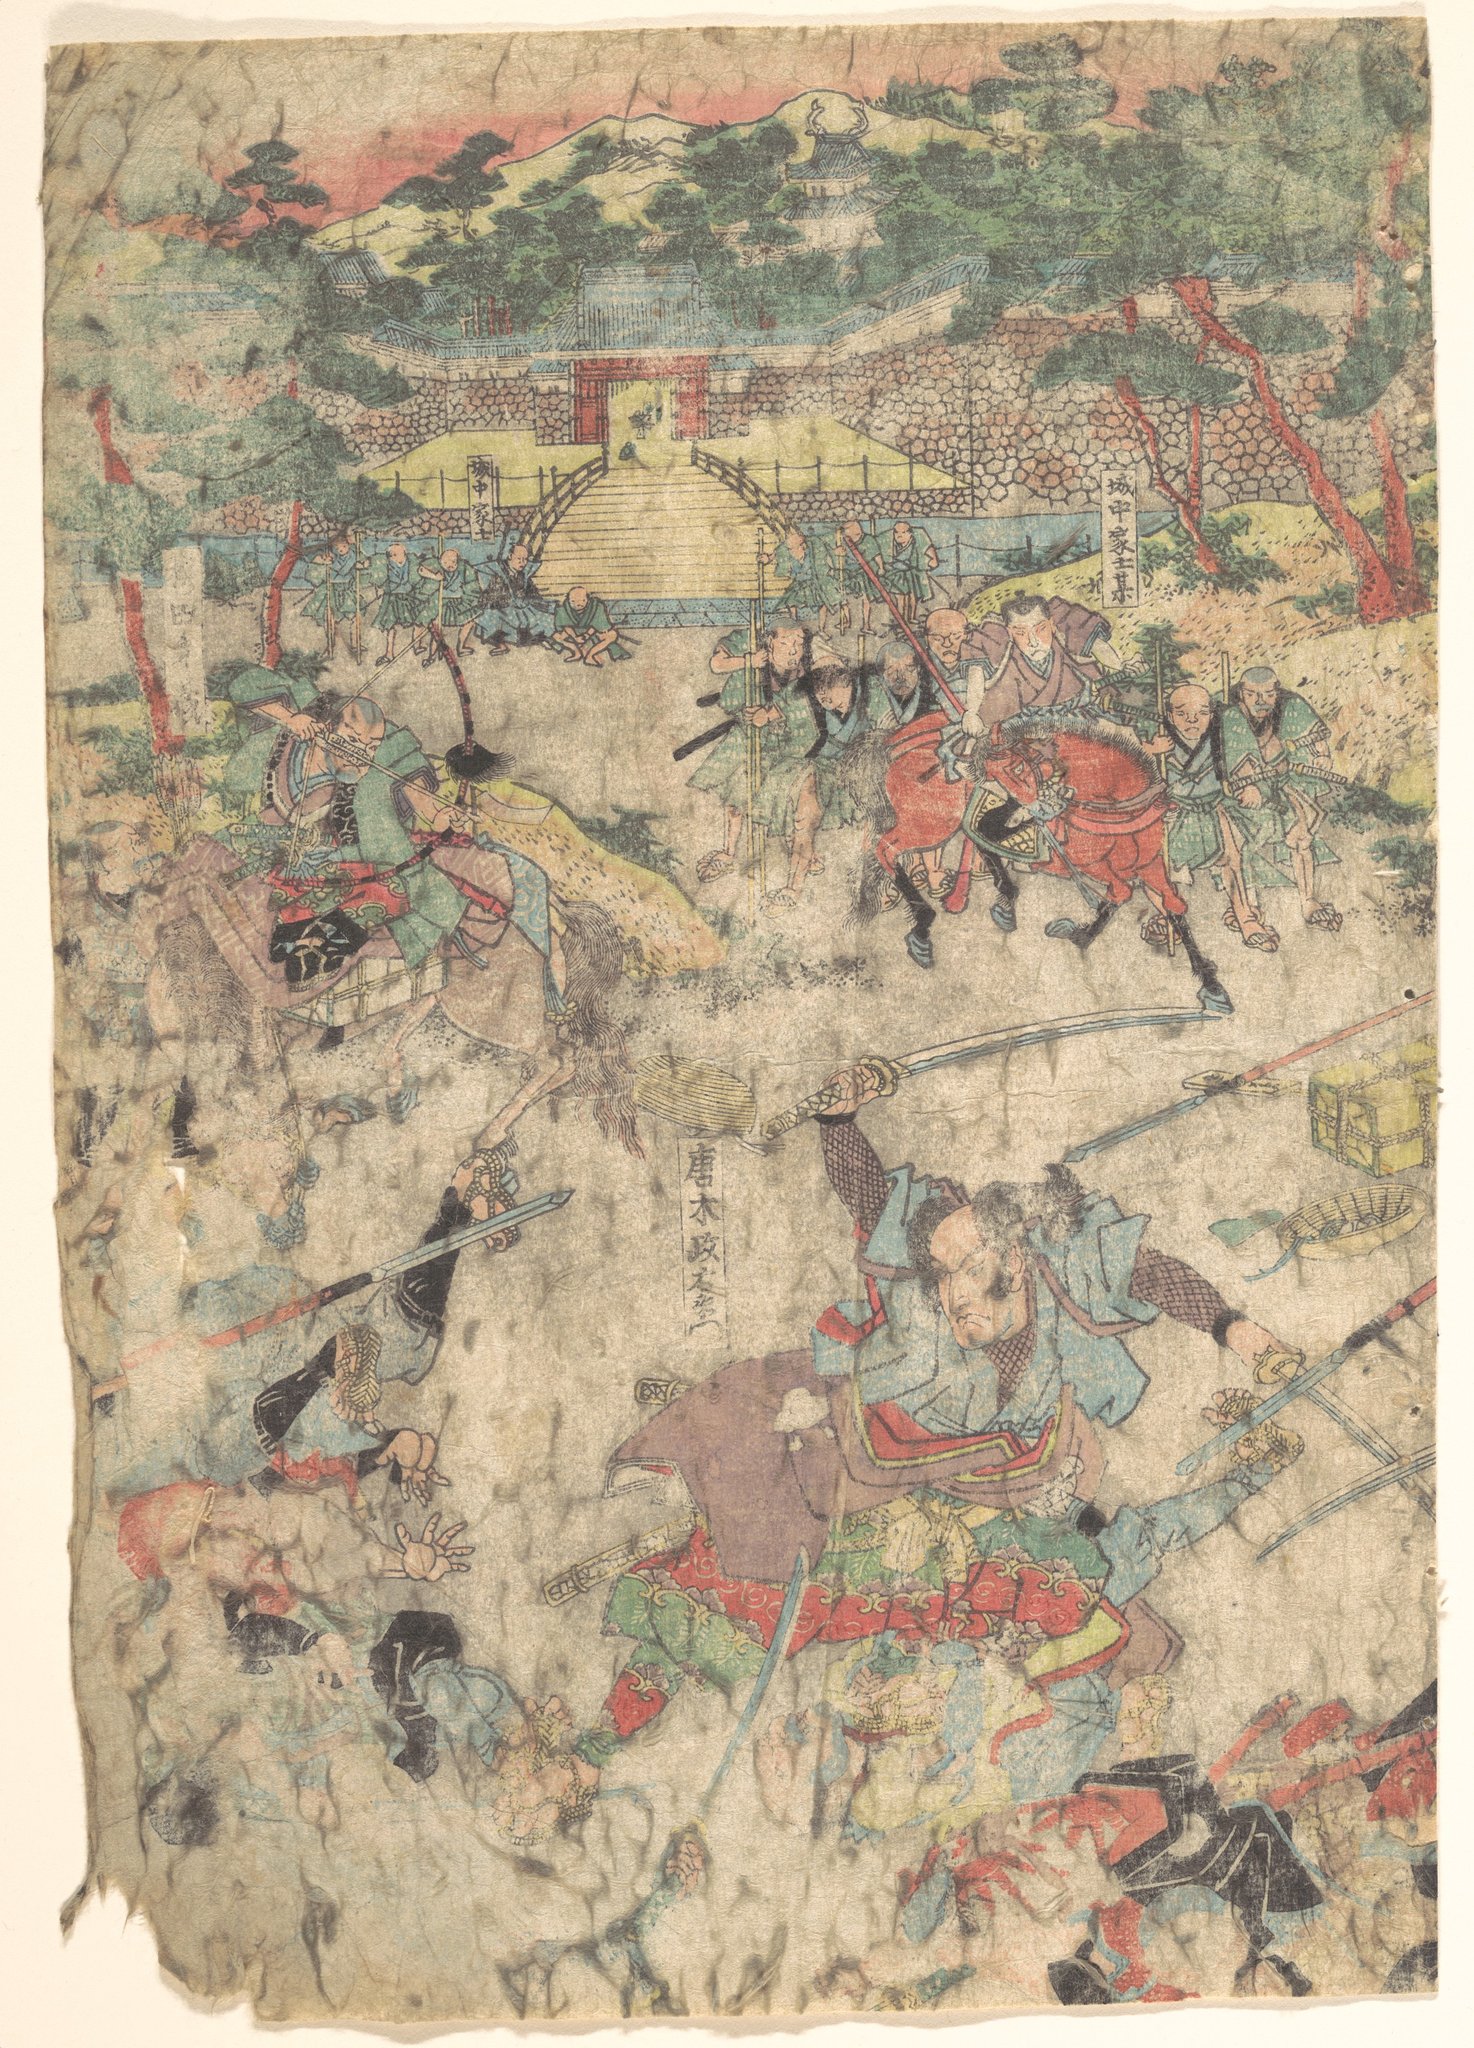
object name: print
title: Karaki Masaemon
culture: japanese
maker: unidentified artist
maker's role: artist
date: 1801-1900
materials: ink, paper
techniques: woodblock print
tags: weapons,men,horses,trees